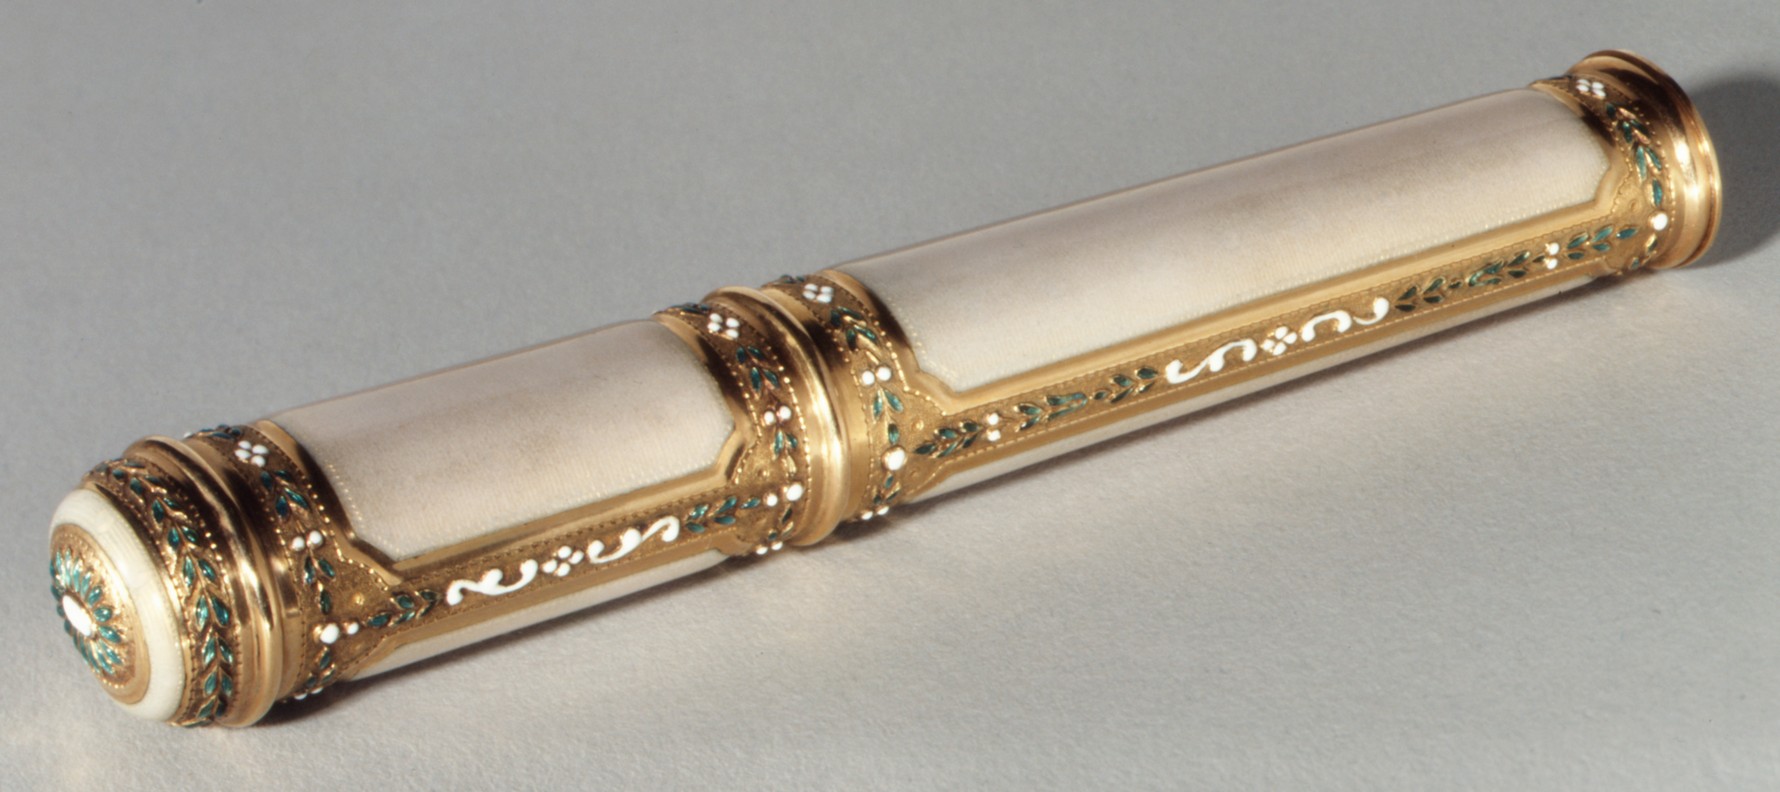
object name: étui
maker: toussaint-françois pillieux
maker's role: maker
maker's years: 1786-1806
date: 1785-1786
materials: enamel, gold